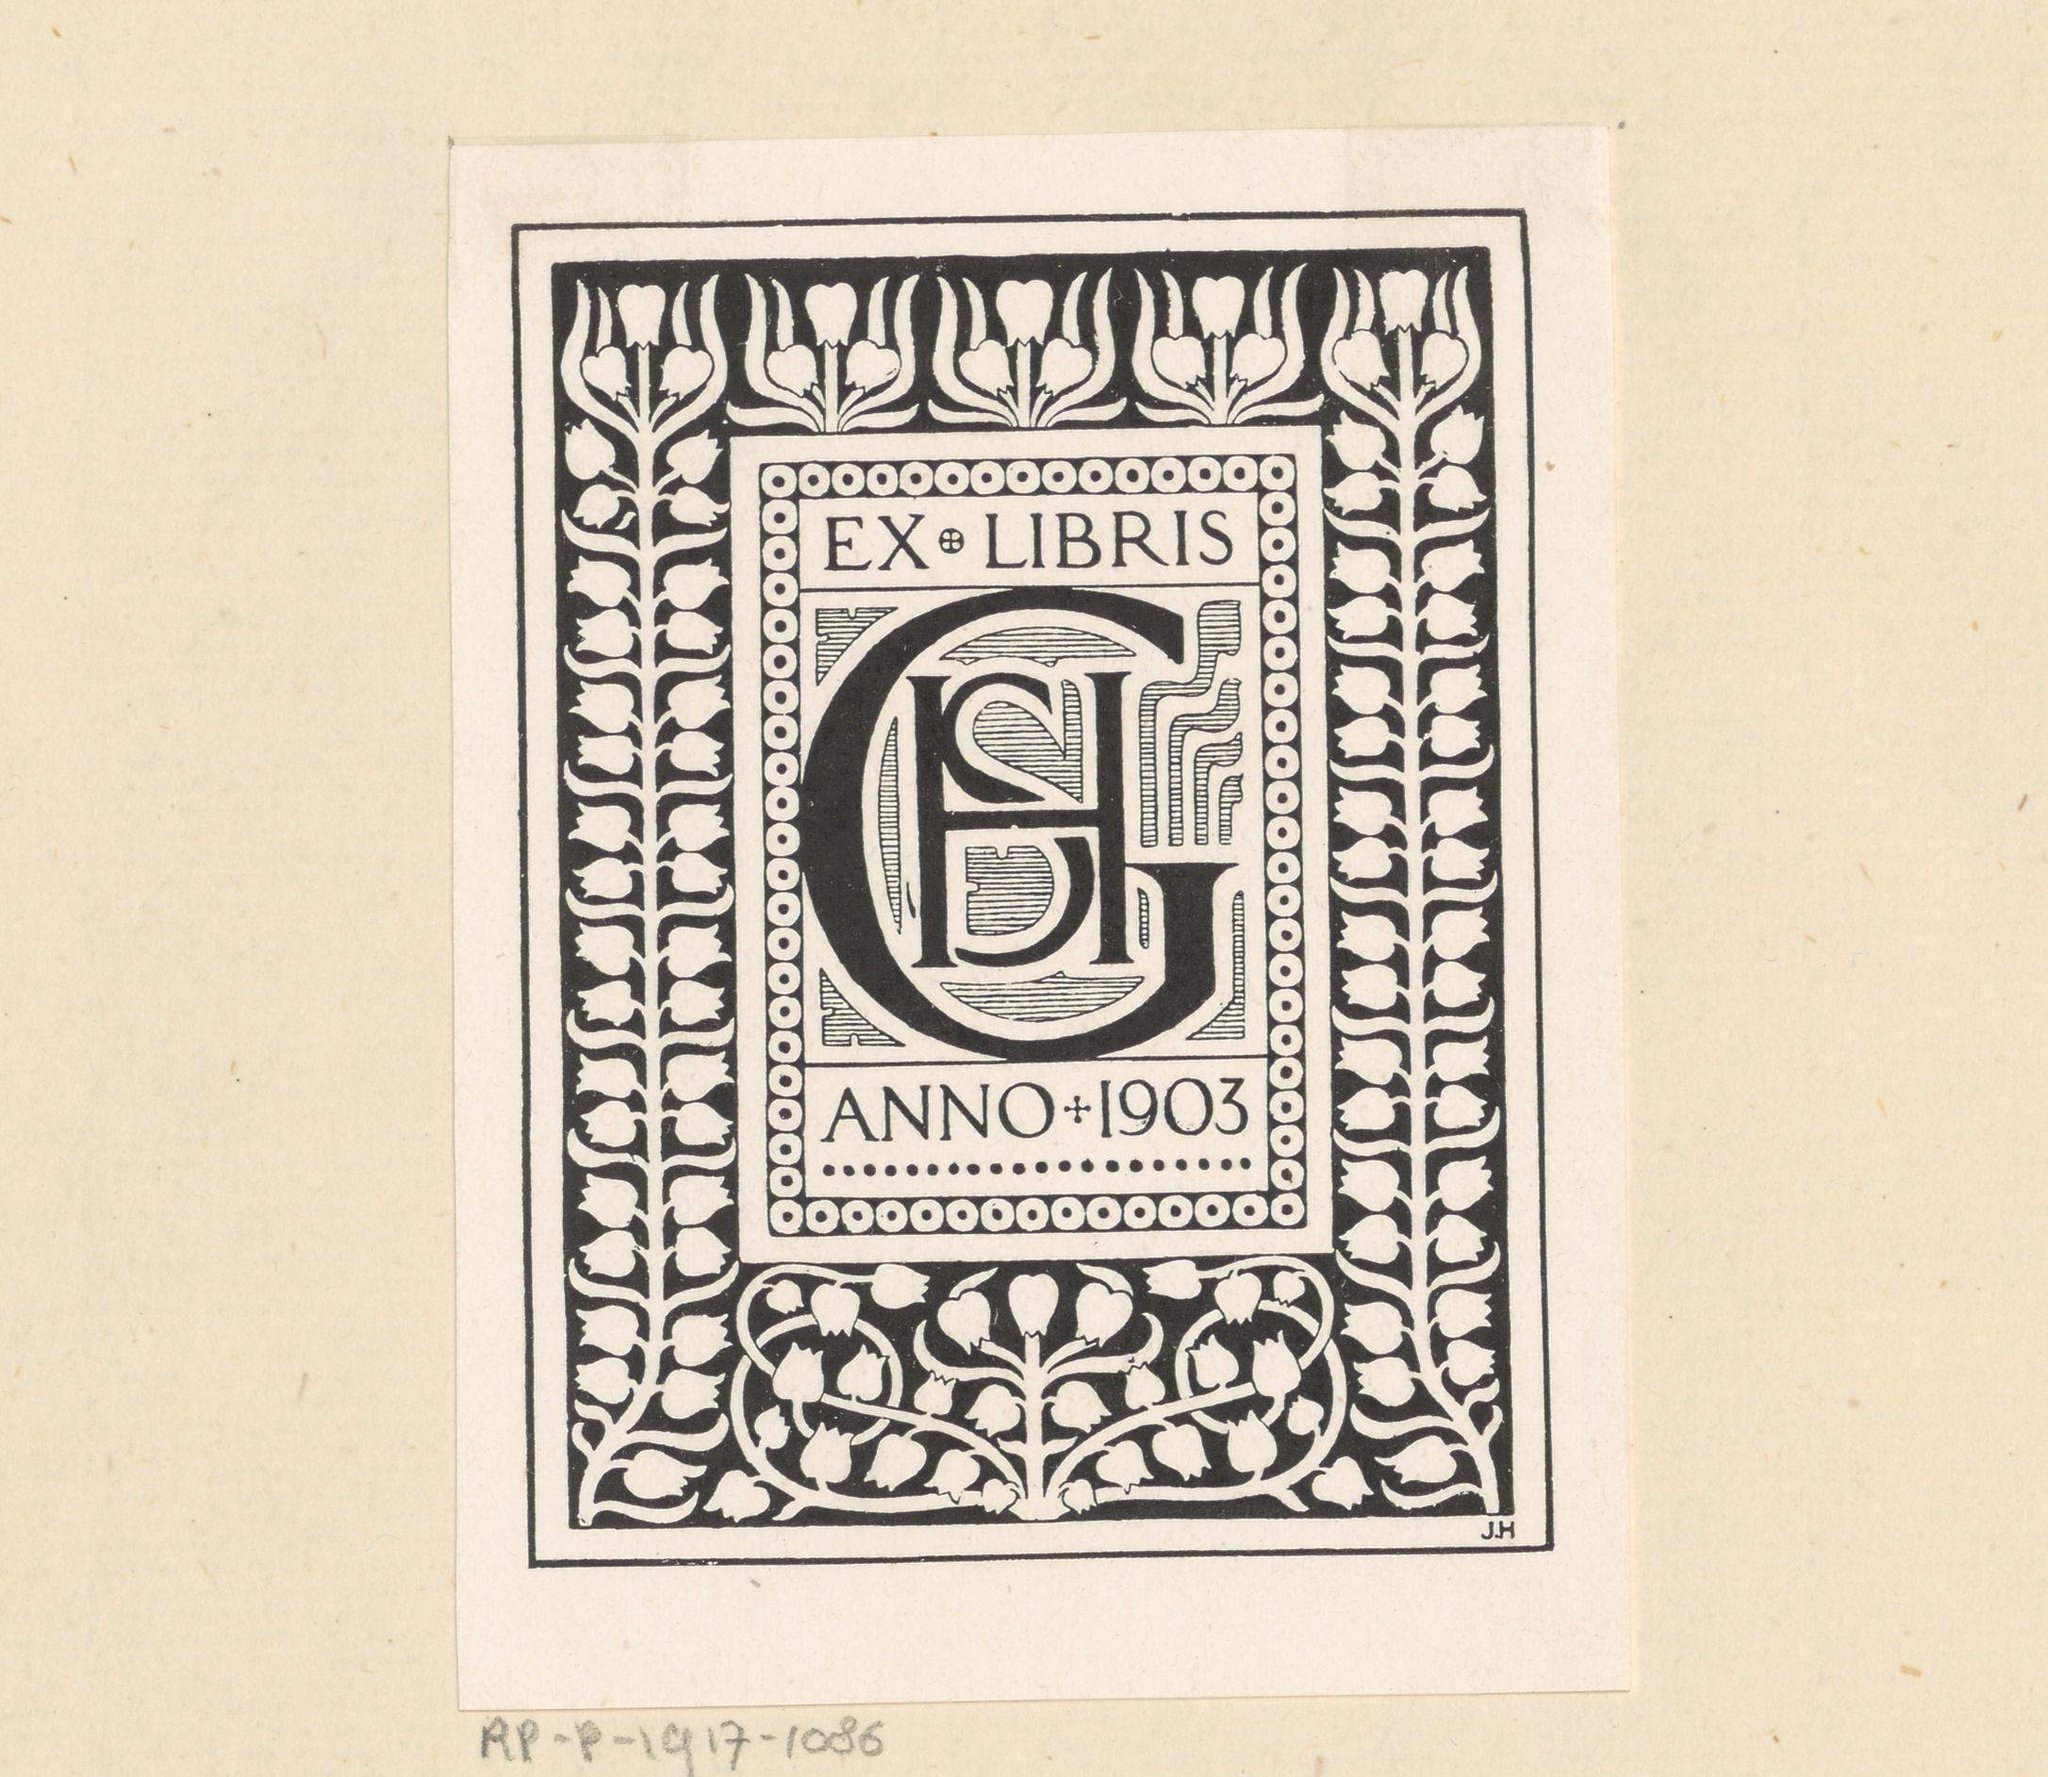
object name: bookplate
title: Ex libris van S.H. Gorter-Hertz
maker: jan h.l. hanau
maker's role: draughtsman, print maker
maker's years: 1864-1925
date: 1903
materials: paper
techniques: printing block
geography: netherlands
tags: floral interlace ~ ornament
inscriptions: collector's mark: Lugt 2165